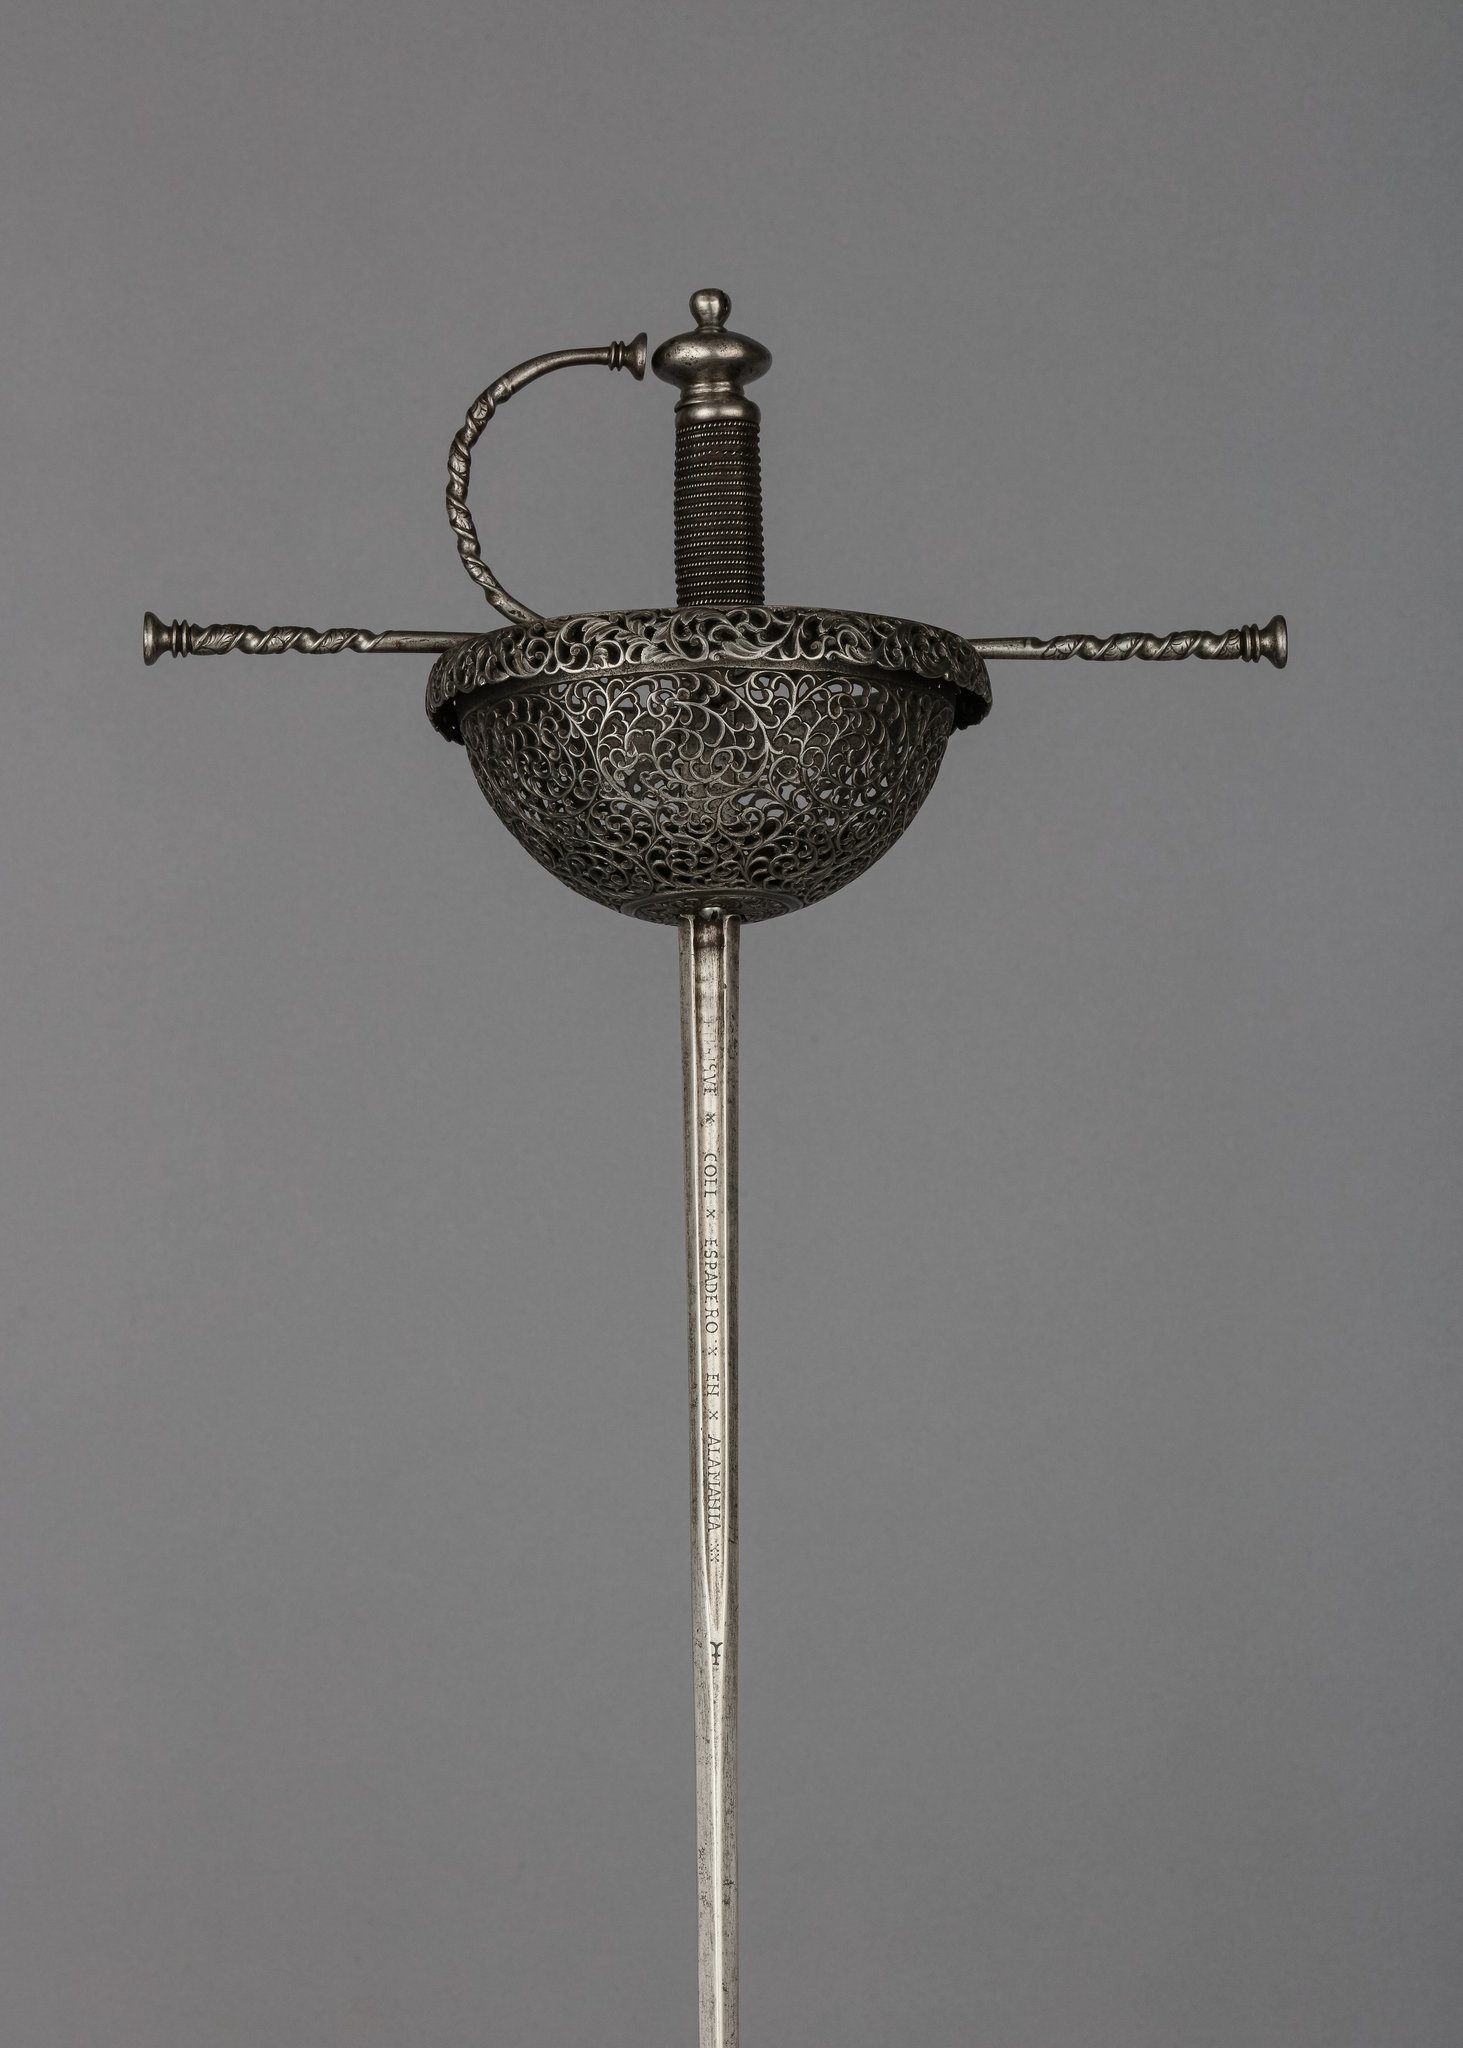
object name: cup hilted rapier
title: Cup-Hilted Rapier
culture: german or spanish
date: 1650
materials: steel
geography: germany